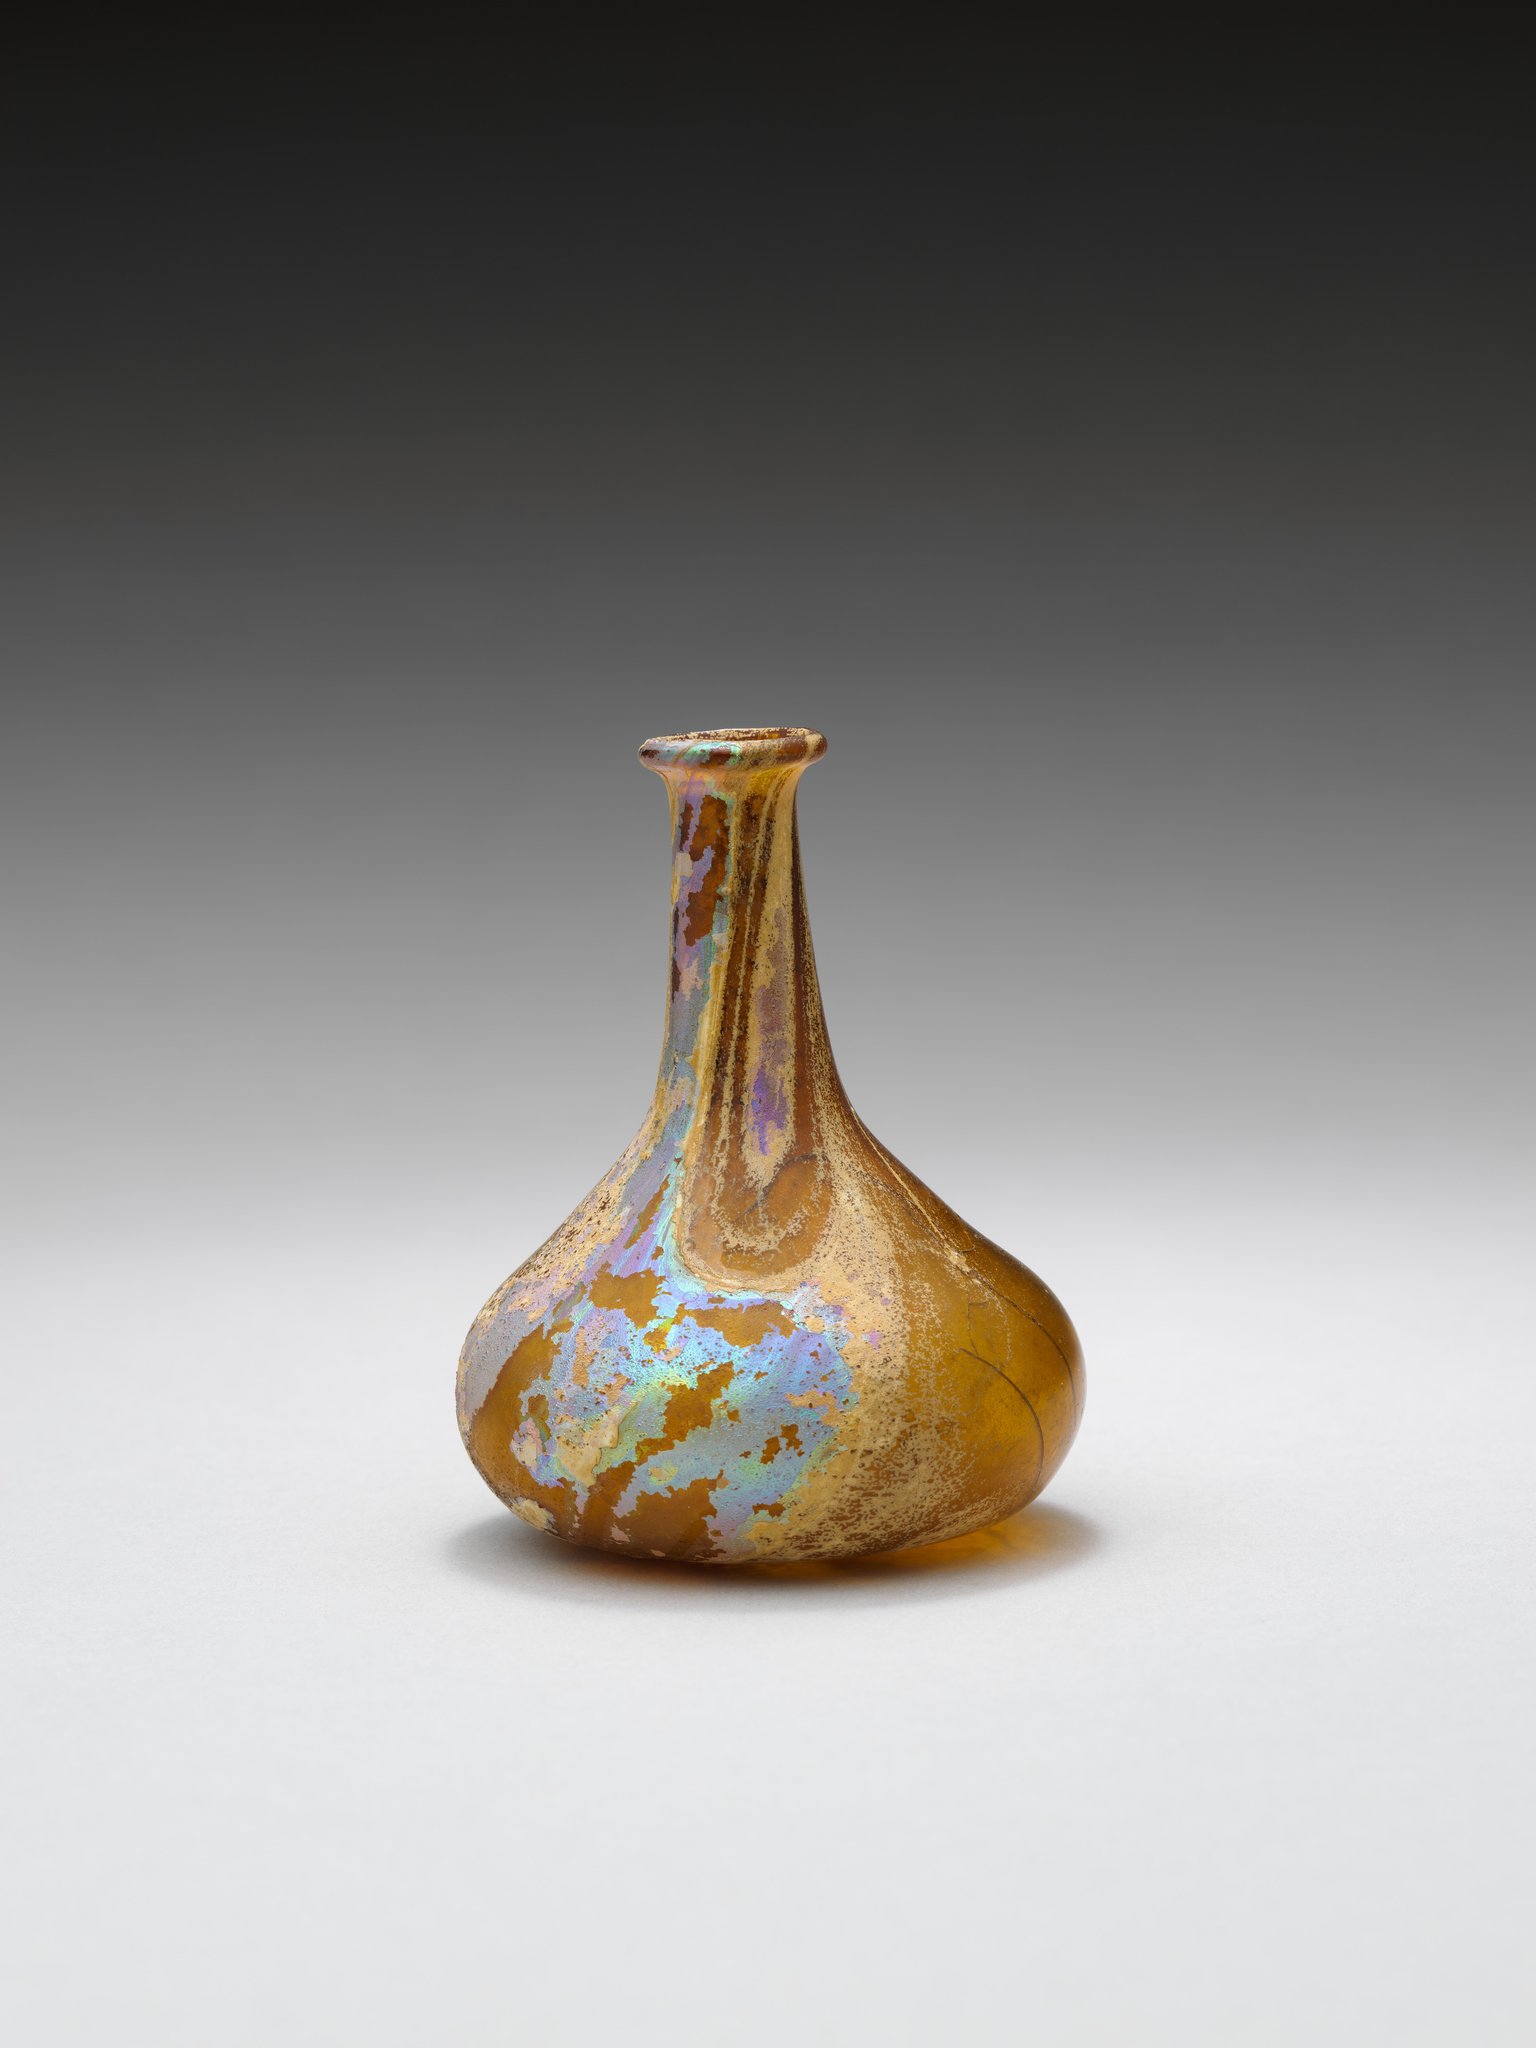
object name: perfume bottle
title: Glass perfume bottle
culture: roman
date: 1-100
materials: glass